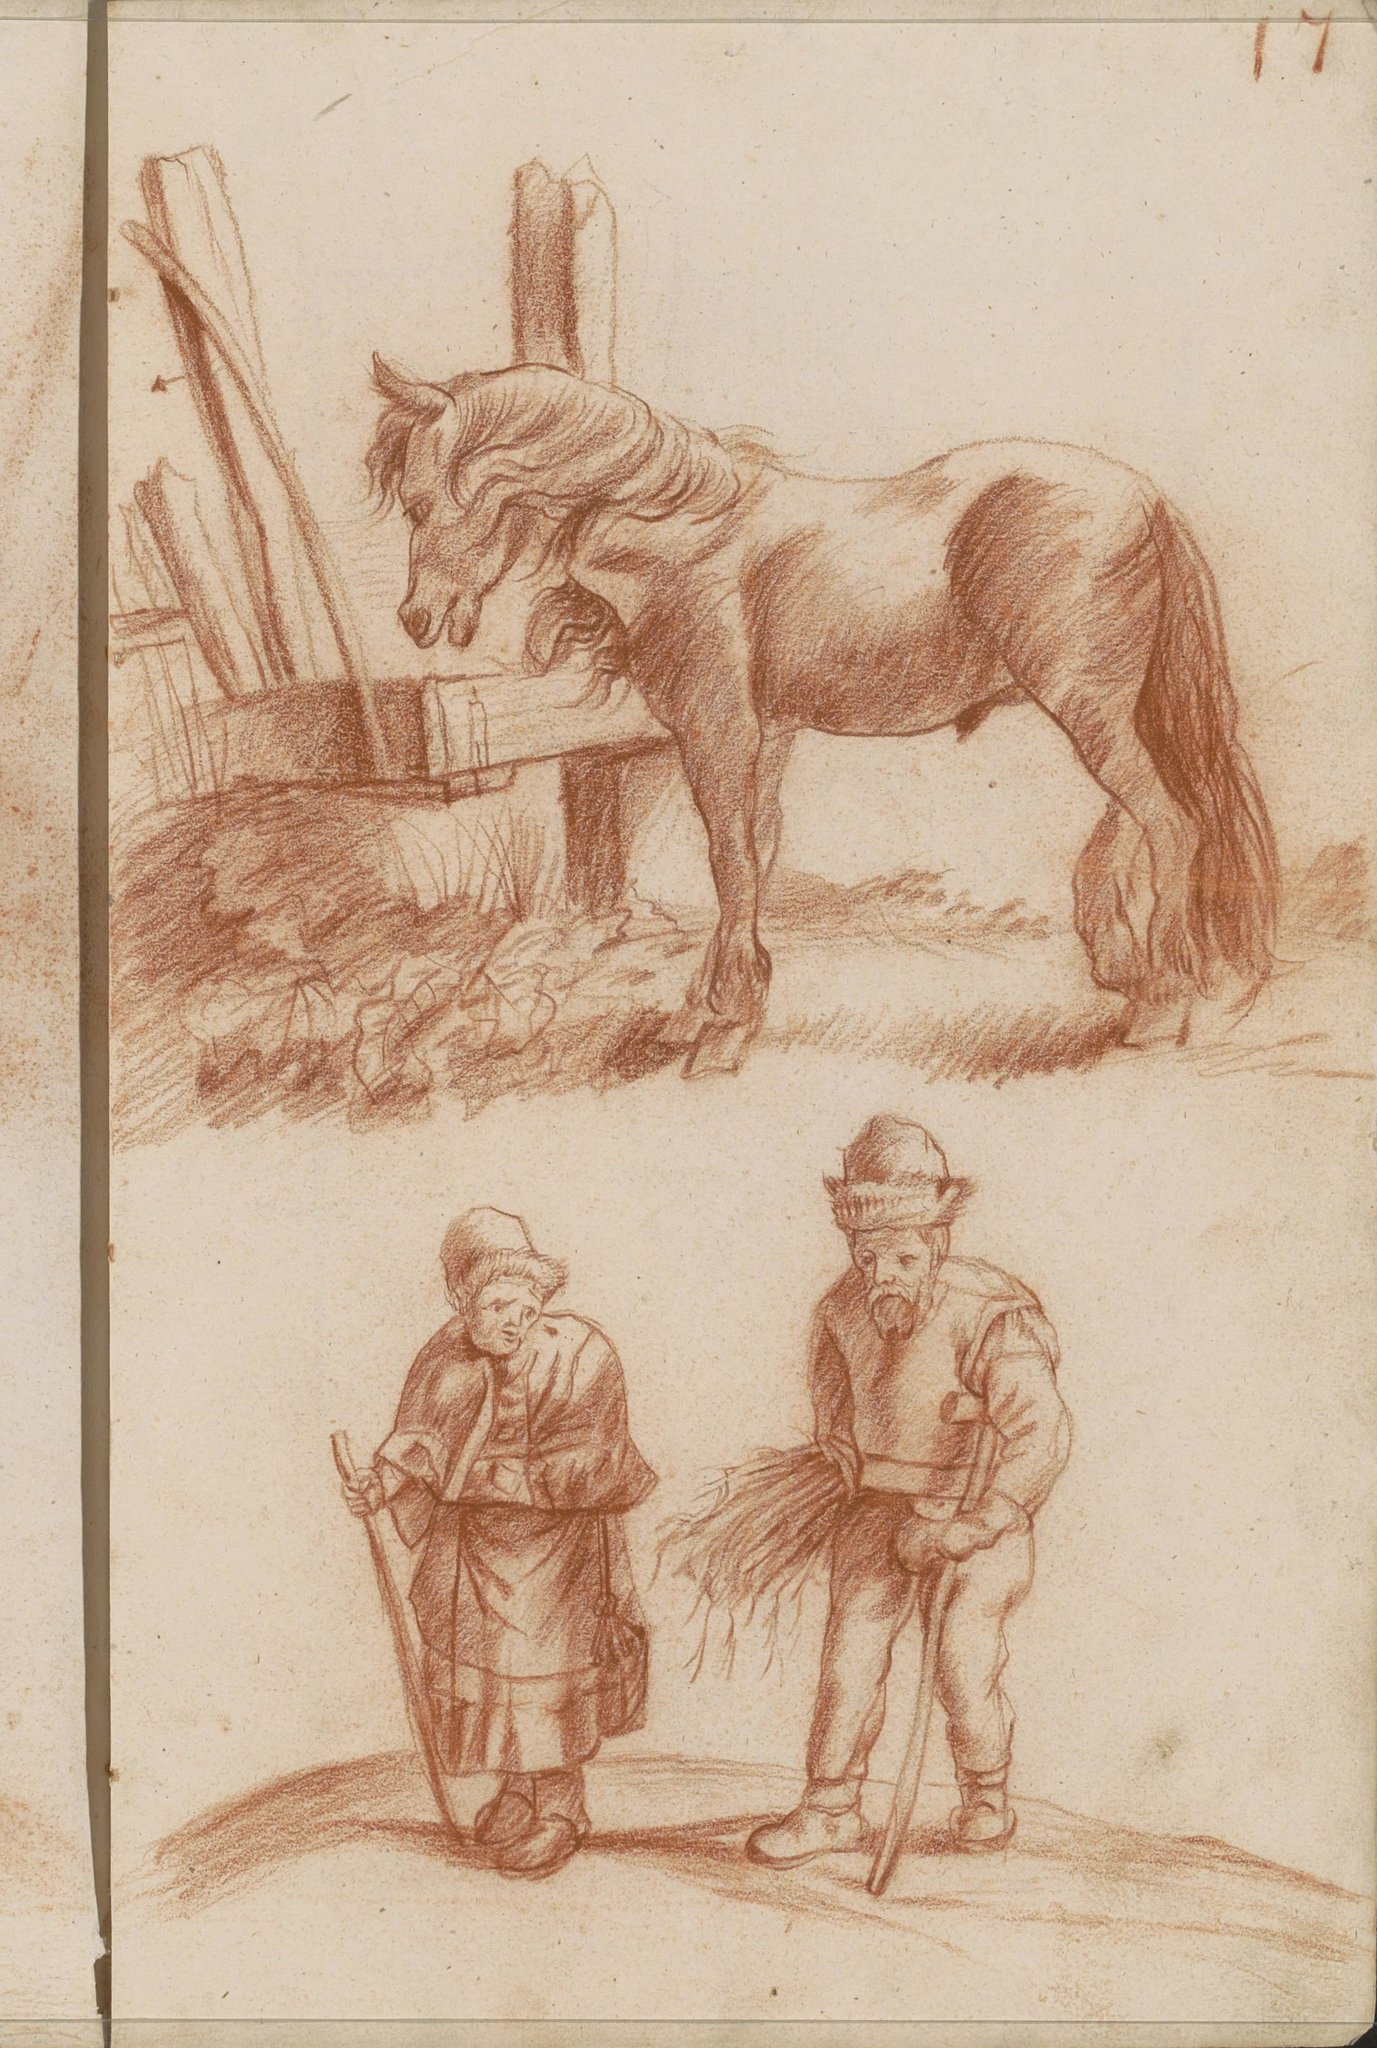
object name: sketchbook leaf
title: Paard en een boerenpaar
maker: hendrick van beaumont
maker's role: draughtsman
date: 1696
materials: chalk, paper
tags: farmers, horse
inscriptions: number: ‘17’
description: De man draagt een bos takken onder zijn arm. Blad 14 recto uit een schetsboek met 30 bladen.